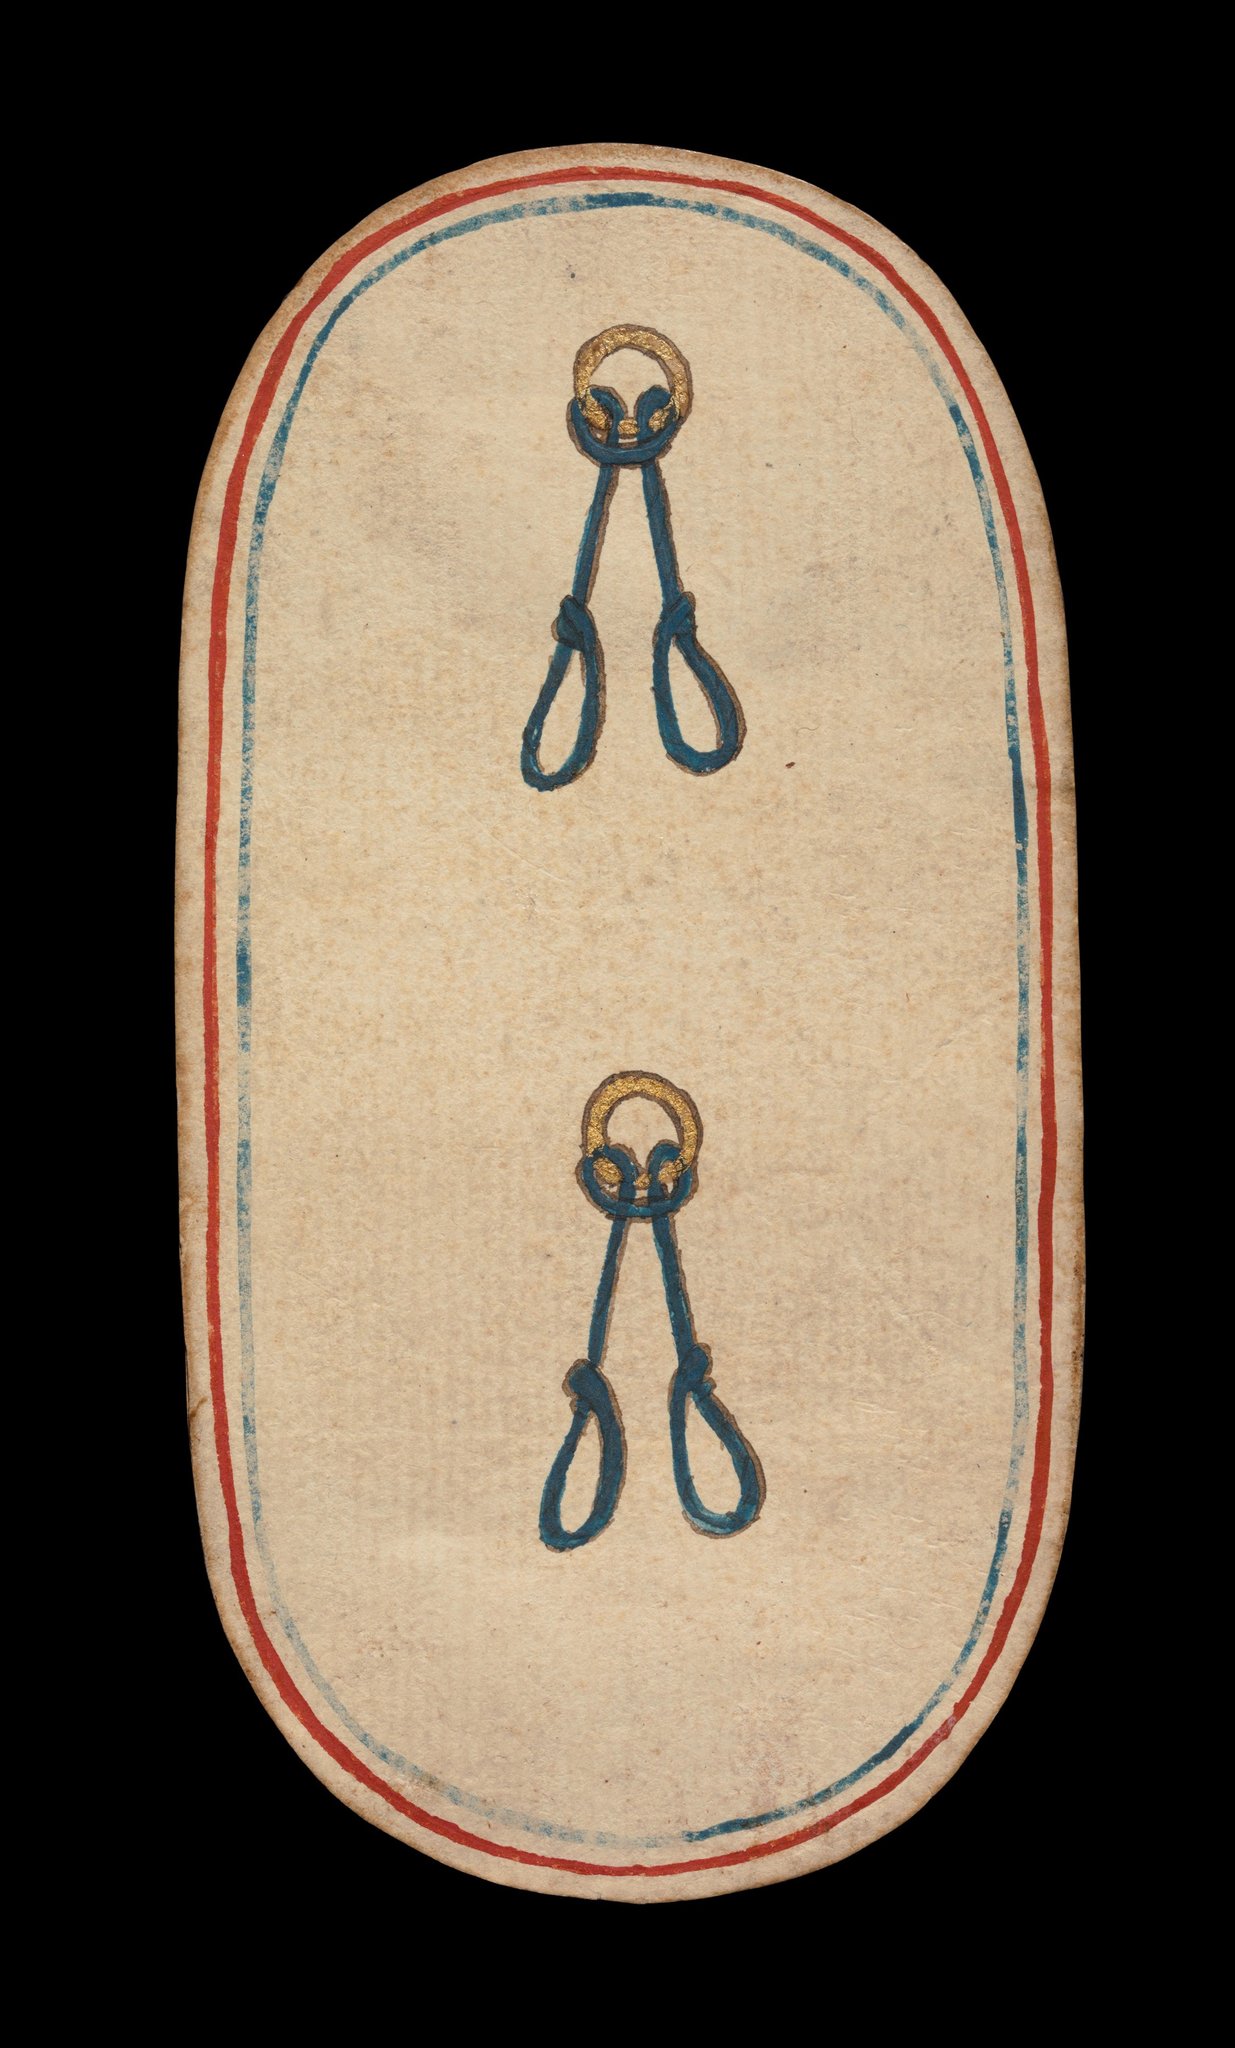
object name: playing card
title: 2 of Nooses, from The Cloisters Playing Cards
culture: south netherlandish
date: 1475-1480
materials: glaze, gold, ink, paint, paper, silver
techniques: pen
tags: playing cards,games